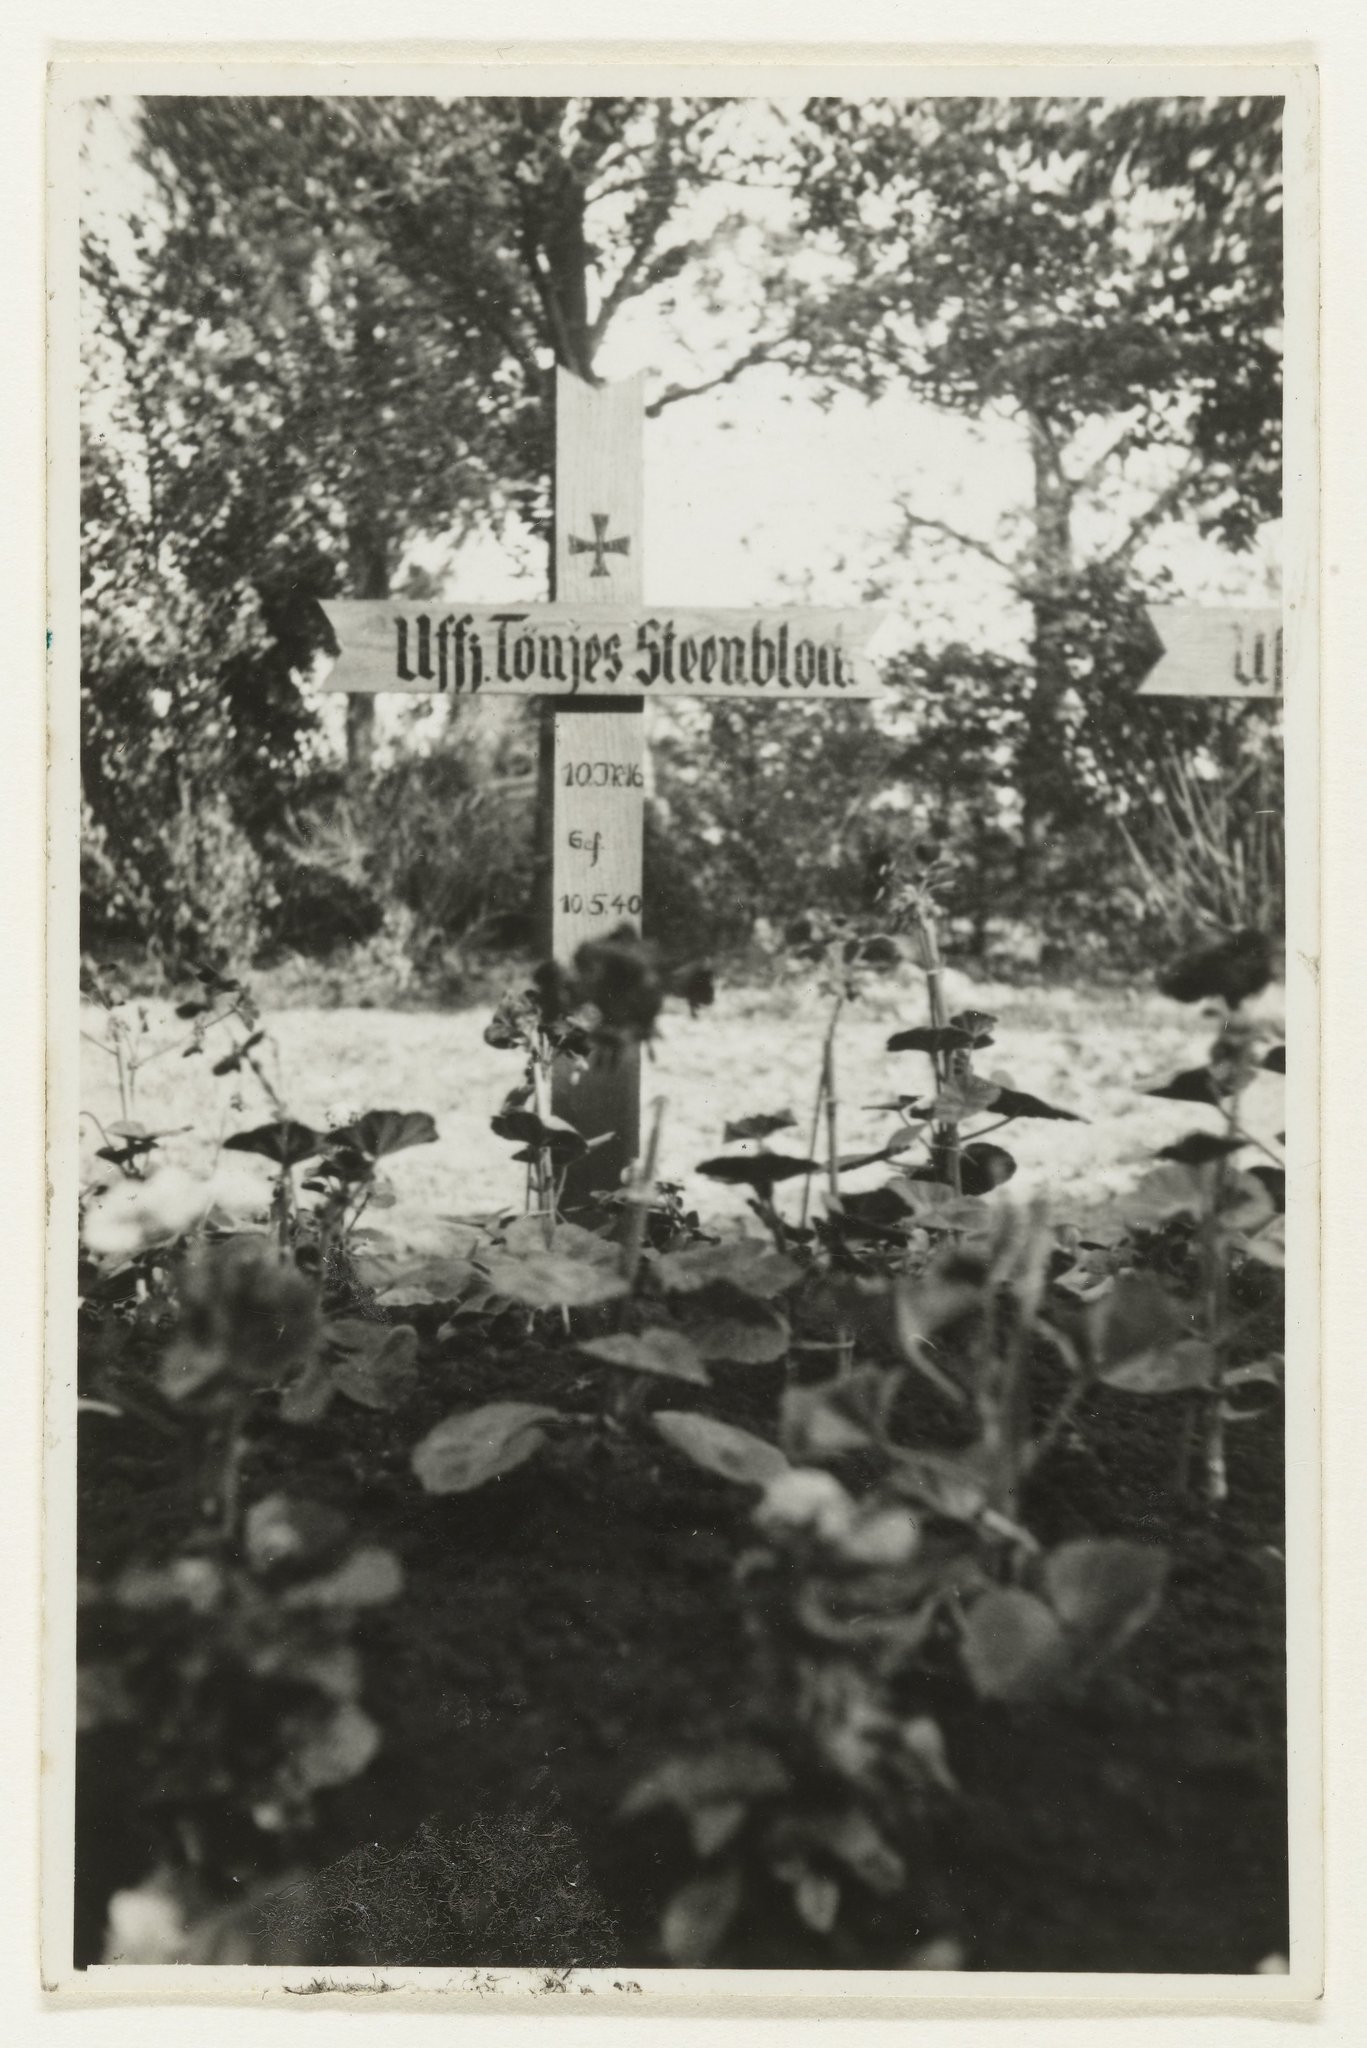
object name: photograph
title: Begraafplaats Duitse militairen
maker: Anonymous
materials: photographic support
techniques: gelatin silver print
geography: rotterdam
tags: churchyard, cemetery, occupation ~ war, grave, tomb and other grave-forms and grave-markers, rotterdam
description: Een begraafplaats met Duitse militairen, Crooswijk. Een wit kruis met naam, geboortedatum en sterfdatum: 10.5.1940